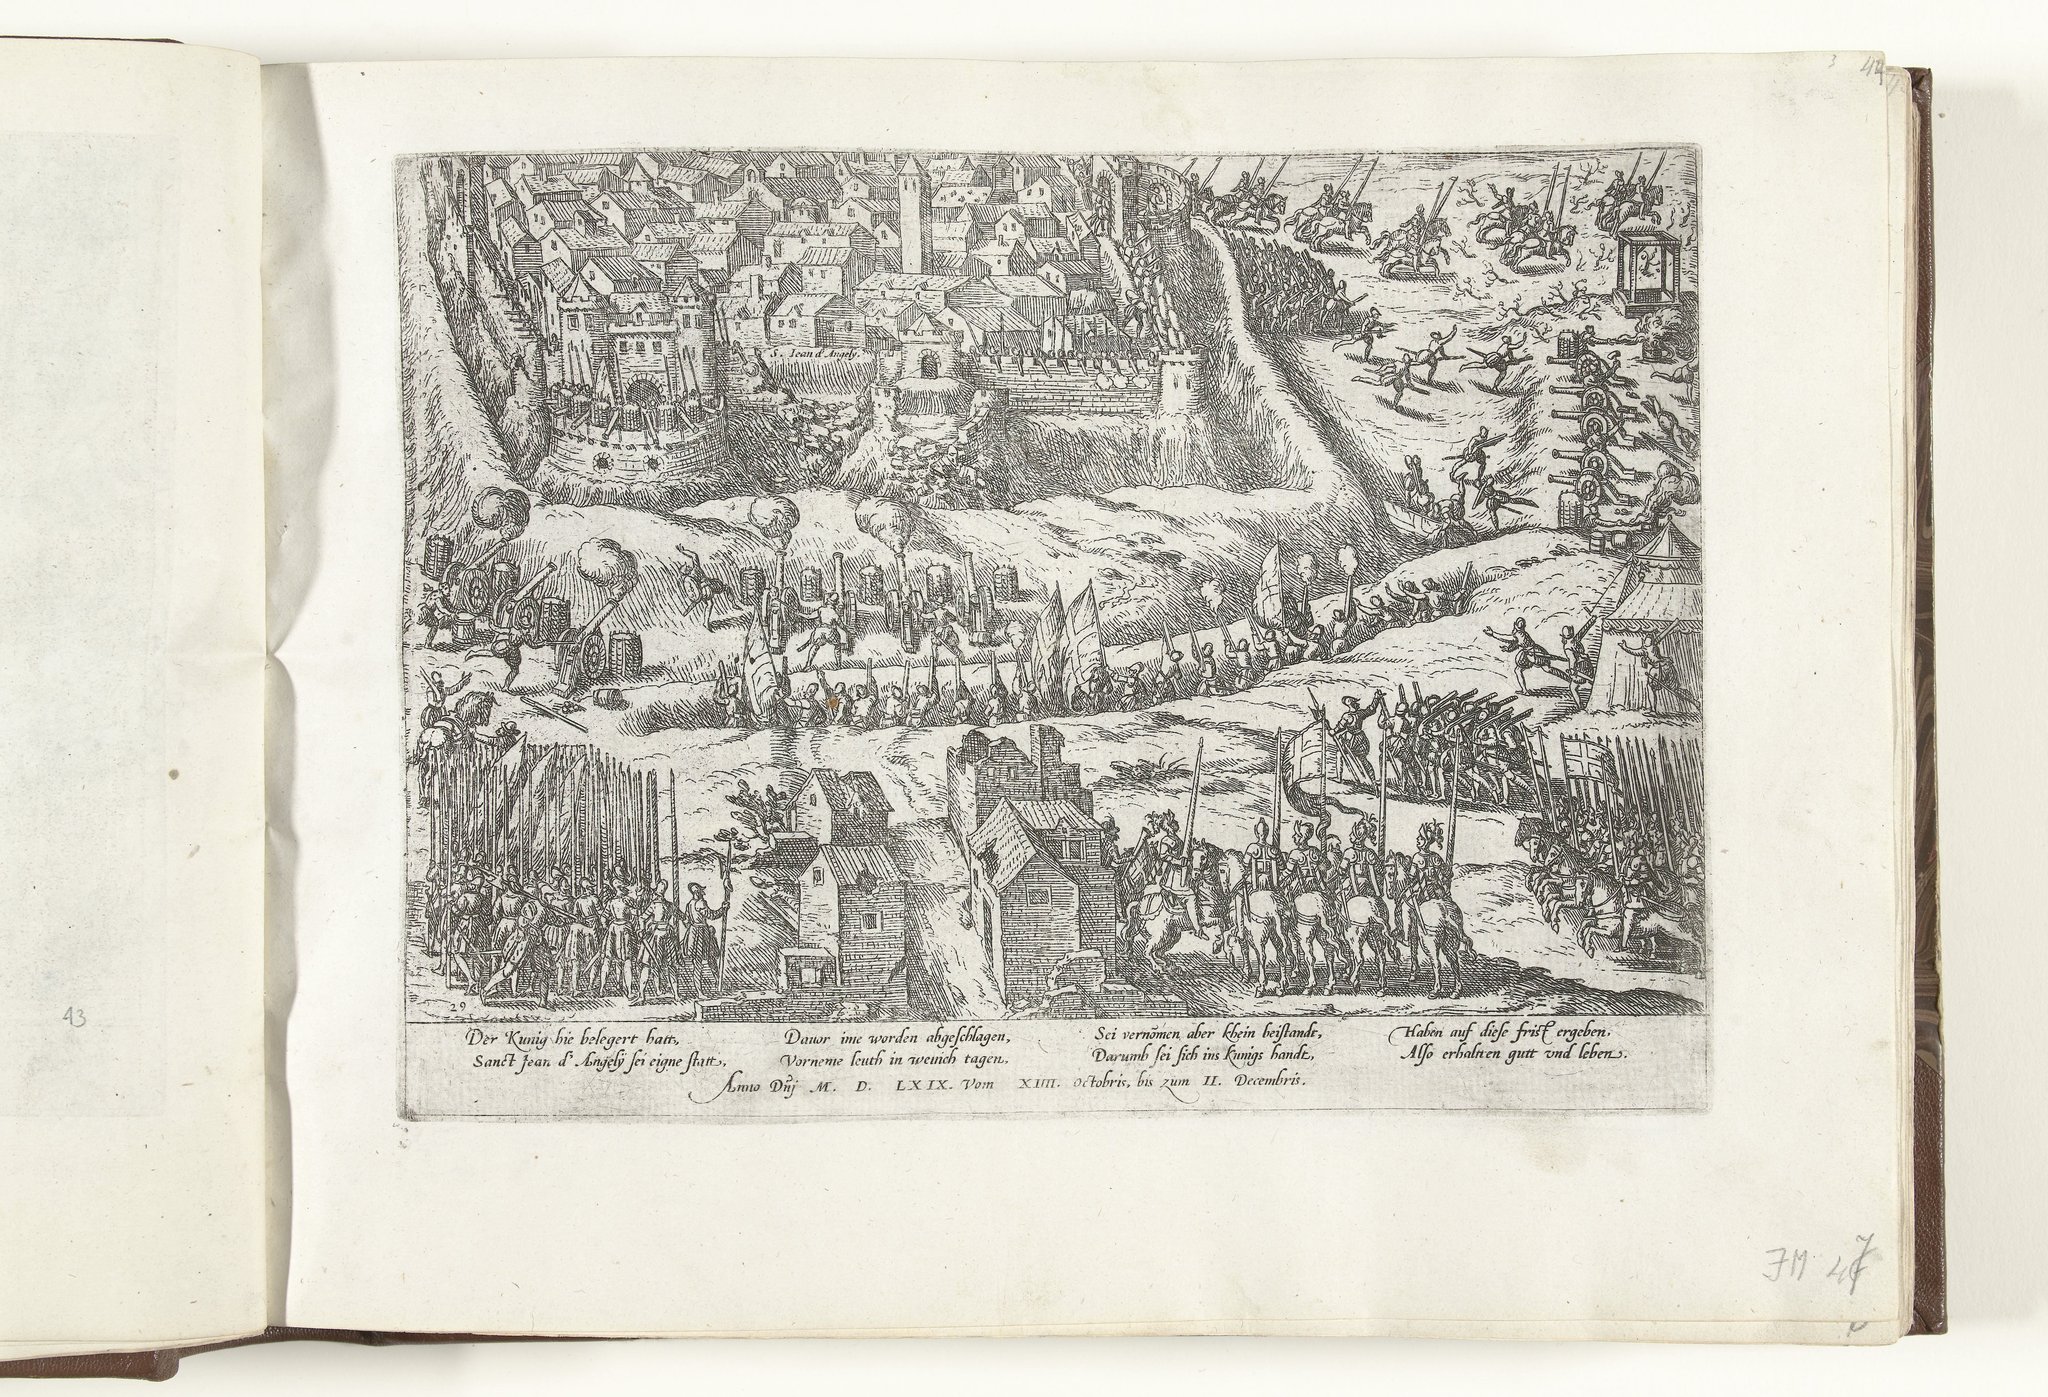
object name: history print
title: Serie 3: Franse Godsdienstoorlogen, 1559-1573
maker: frans hogenberg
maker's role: print maker, publisher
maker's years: 1538-1590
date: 1565-1573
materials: paper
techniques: etching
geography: cologne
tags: karel ix (koning van frankrijk), siege, position war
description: Gekopieerd naar de prent in: Jean Tortorel et Jacques Perrissin, Premier volume contenant quarante tableaux ou Histoires diverses qui sont memorables touchant les Guerres, Massacres et Troubles advenus en France en ces dernieres annees : le tout recueilly selon le tesmoignange de ceux qui y ont esté en personne et qui les ont veus : lesquels sont pourtraits à la vérité, Genève ca. 1570. Bibliotheek Rijksmuseum: 329 A 2, pl. 38.